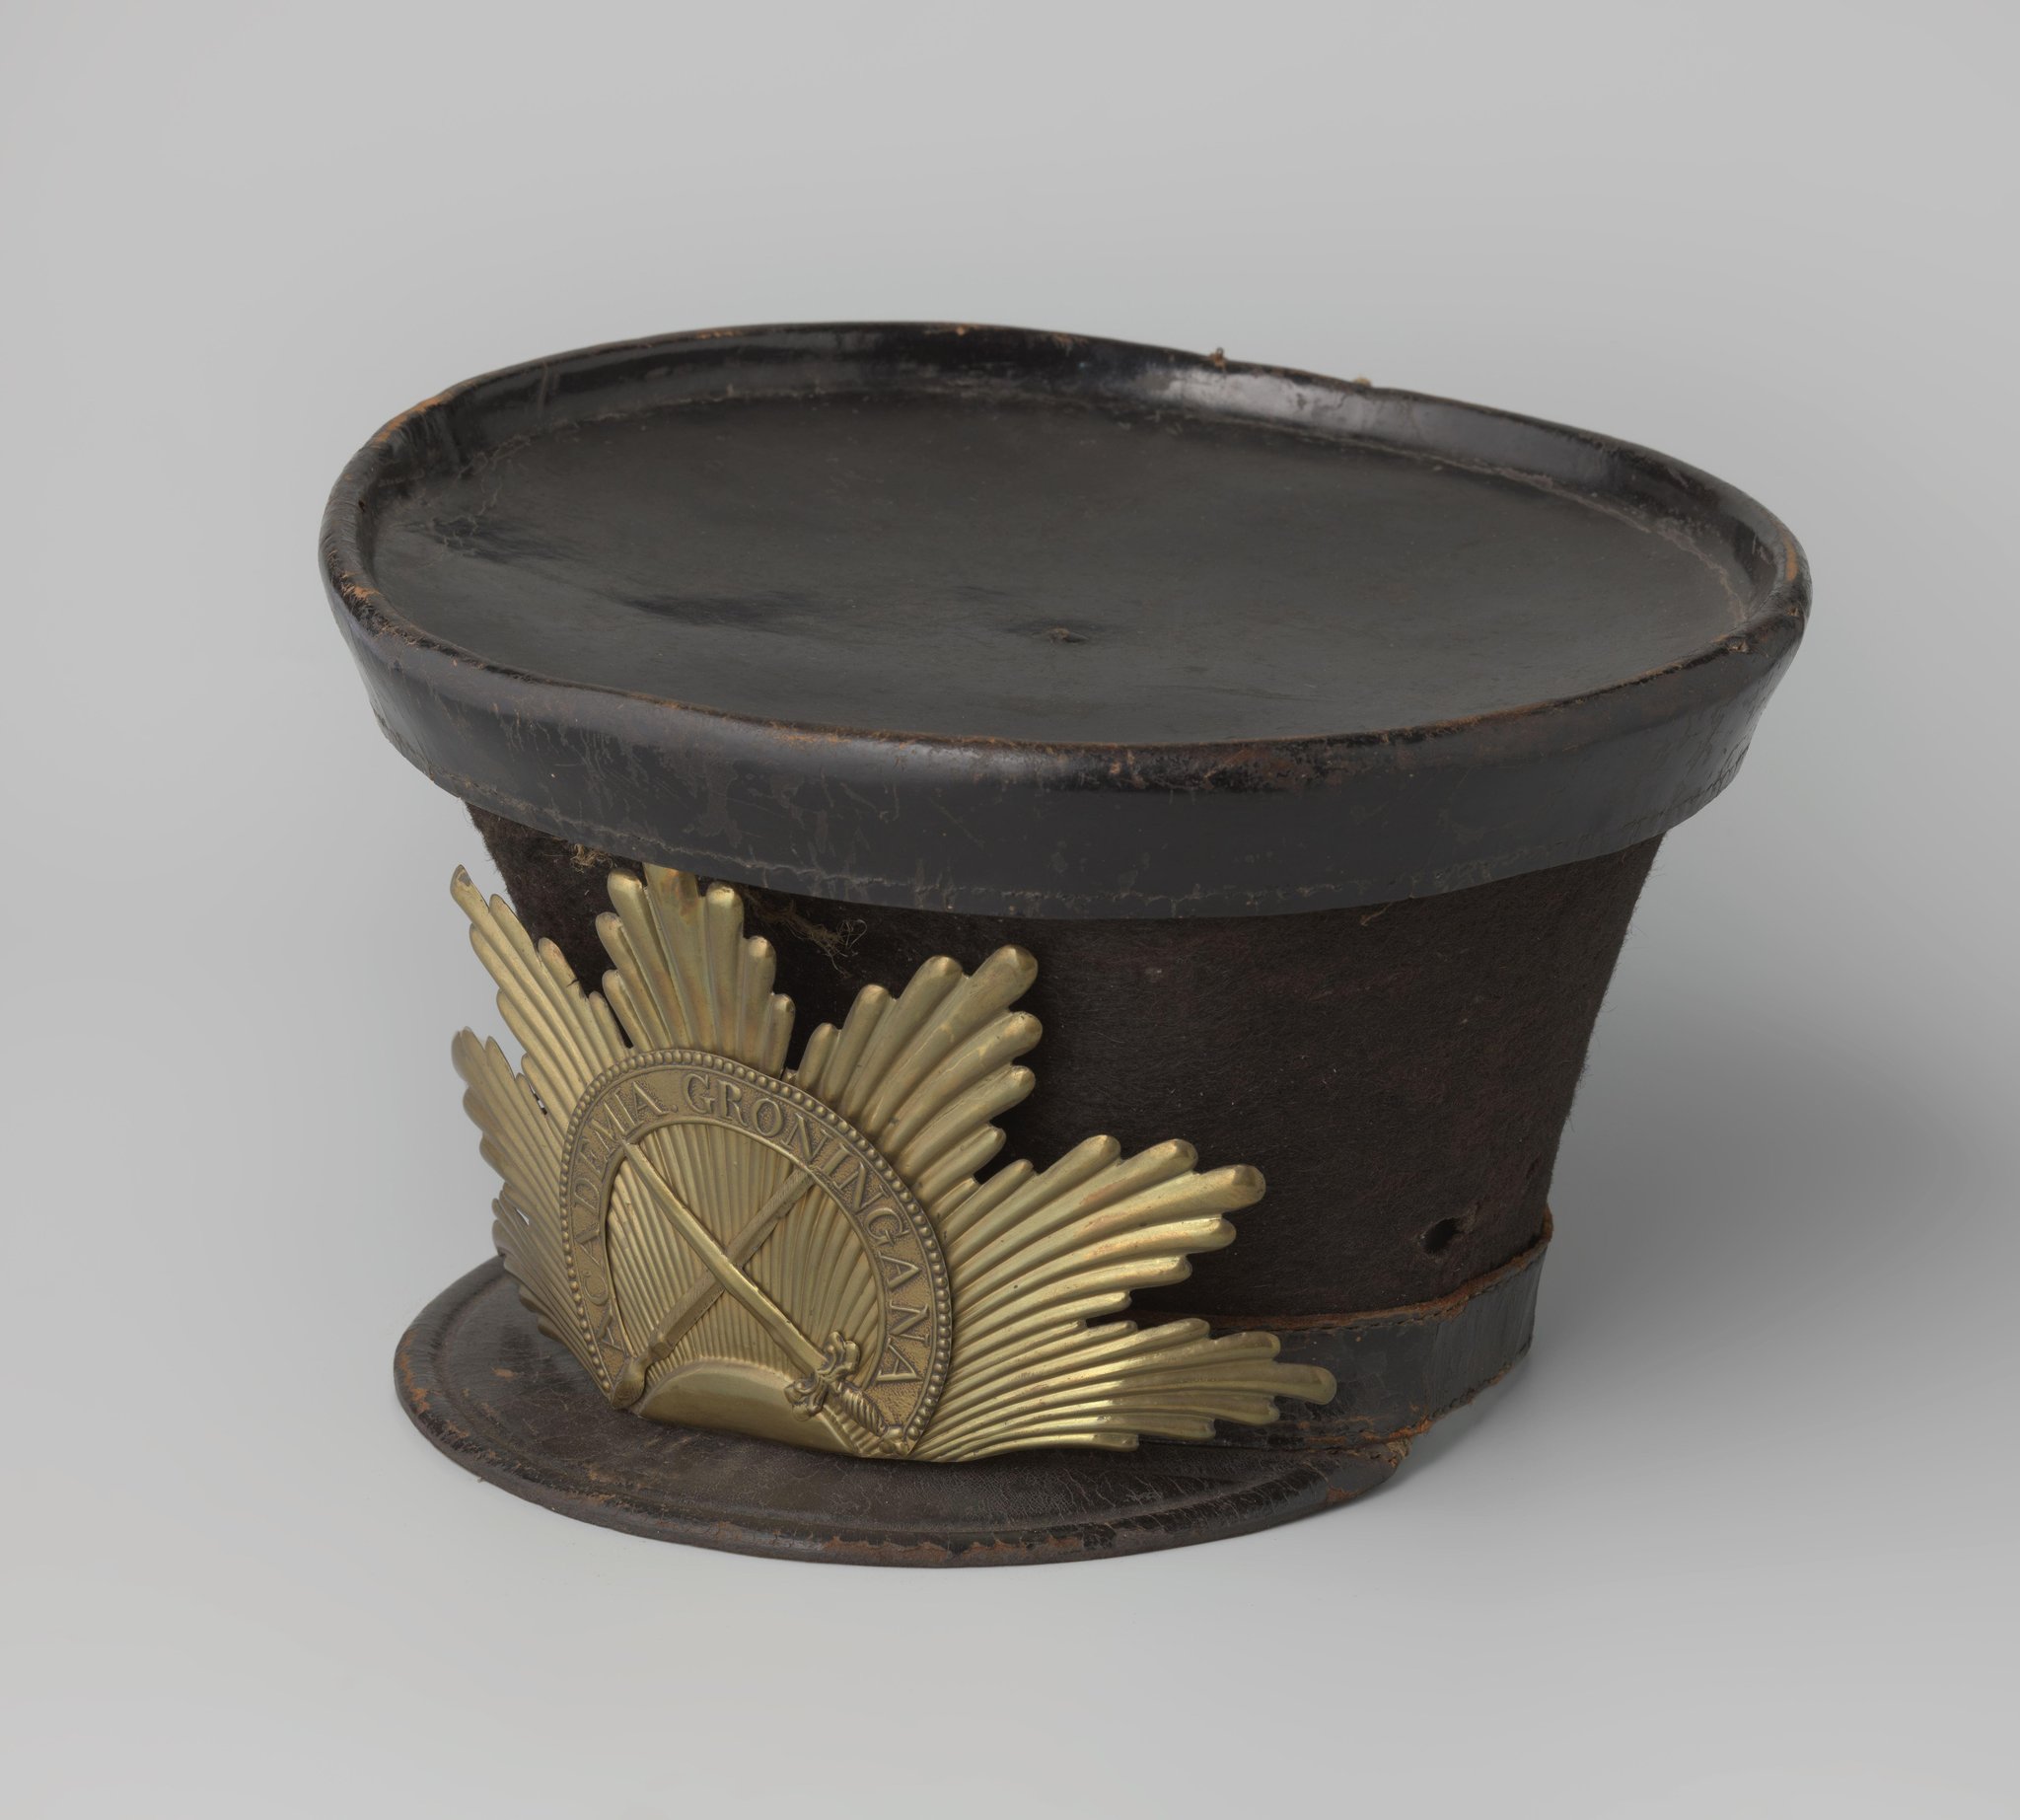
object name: shako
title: Sjako der Flankeurs van de Hoge School te Groningen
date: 1830-1832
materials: cardboard, copper, felt, leather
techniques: lacquer, pressing, stitching, striking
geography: the hague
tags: rijksuniversiteit groningen, koninklijke landmacht, groningen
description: Hoofddeksel van grove stof. Losse zwart leren bodem, waarin geplakt etiket met tekst: Willem Pauwels en zoon, hoedenfabrikeurs, Westeinde B no 317 in Den Haag. Bijna losse zwart leren rand en klep, aan achterzijde rand leren riem met geel metalen gesp. Aan weerzijden corpus elk een gat. Voorzijde corpus: geel metalen sjakoplaat in de vorm van een halve zon. In midden hiervan een cirkel met ontbloot zwaard, en pen (?). Op banderol met gekraalde rand de tekst: 'Academia Groningana'.